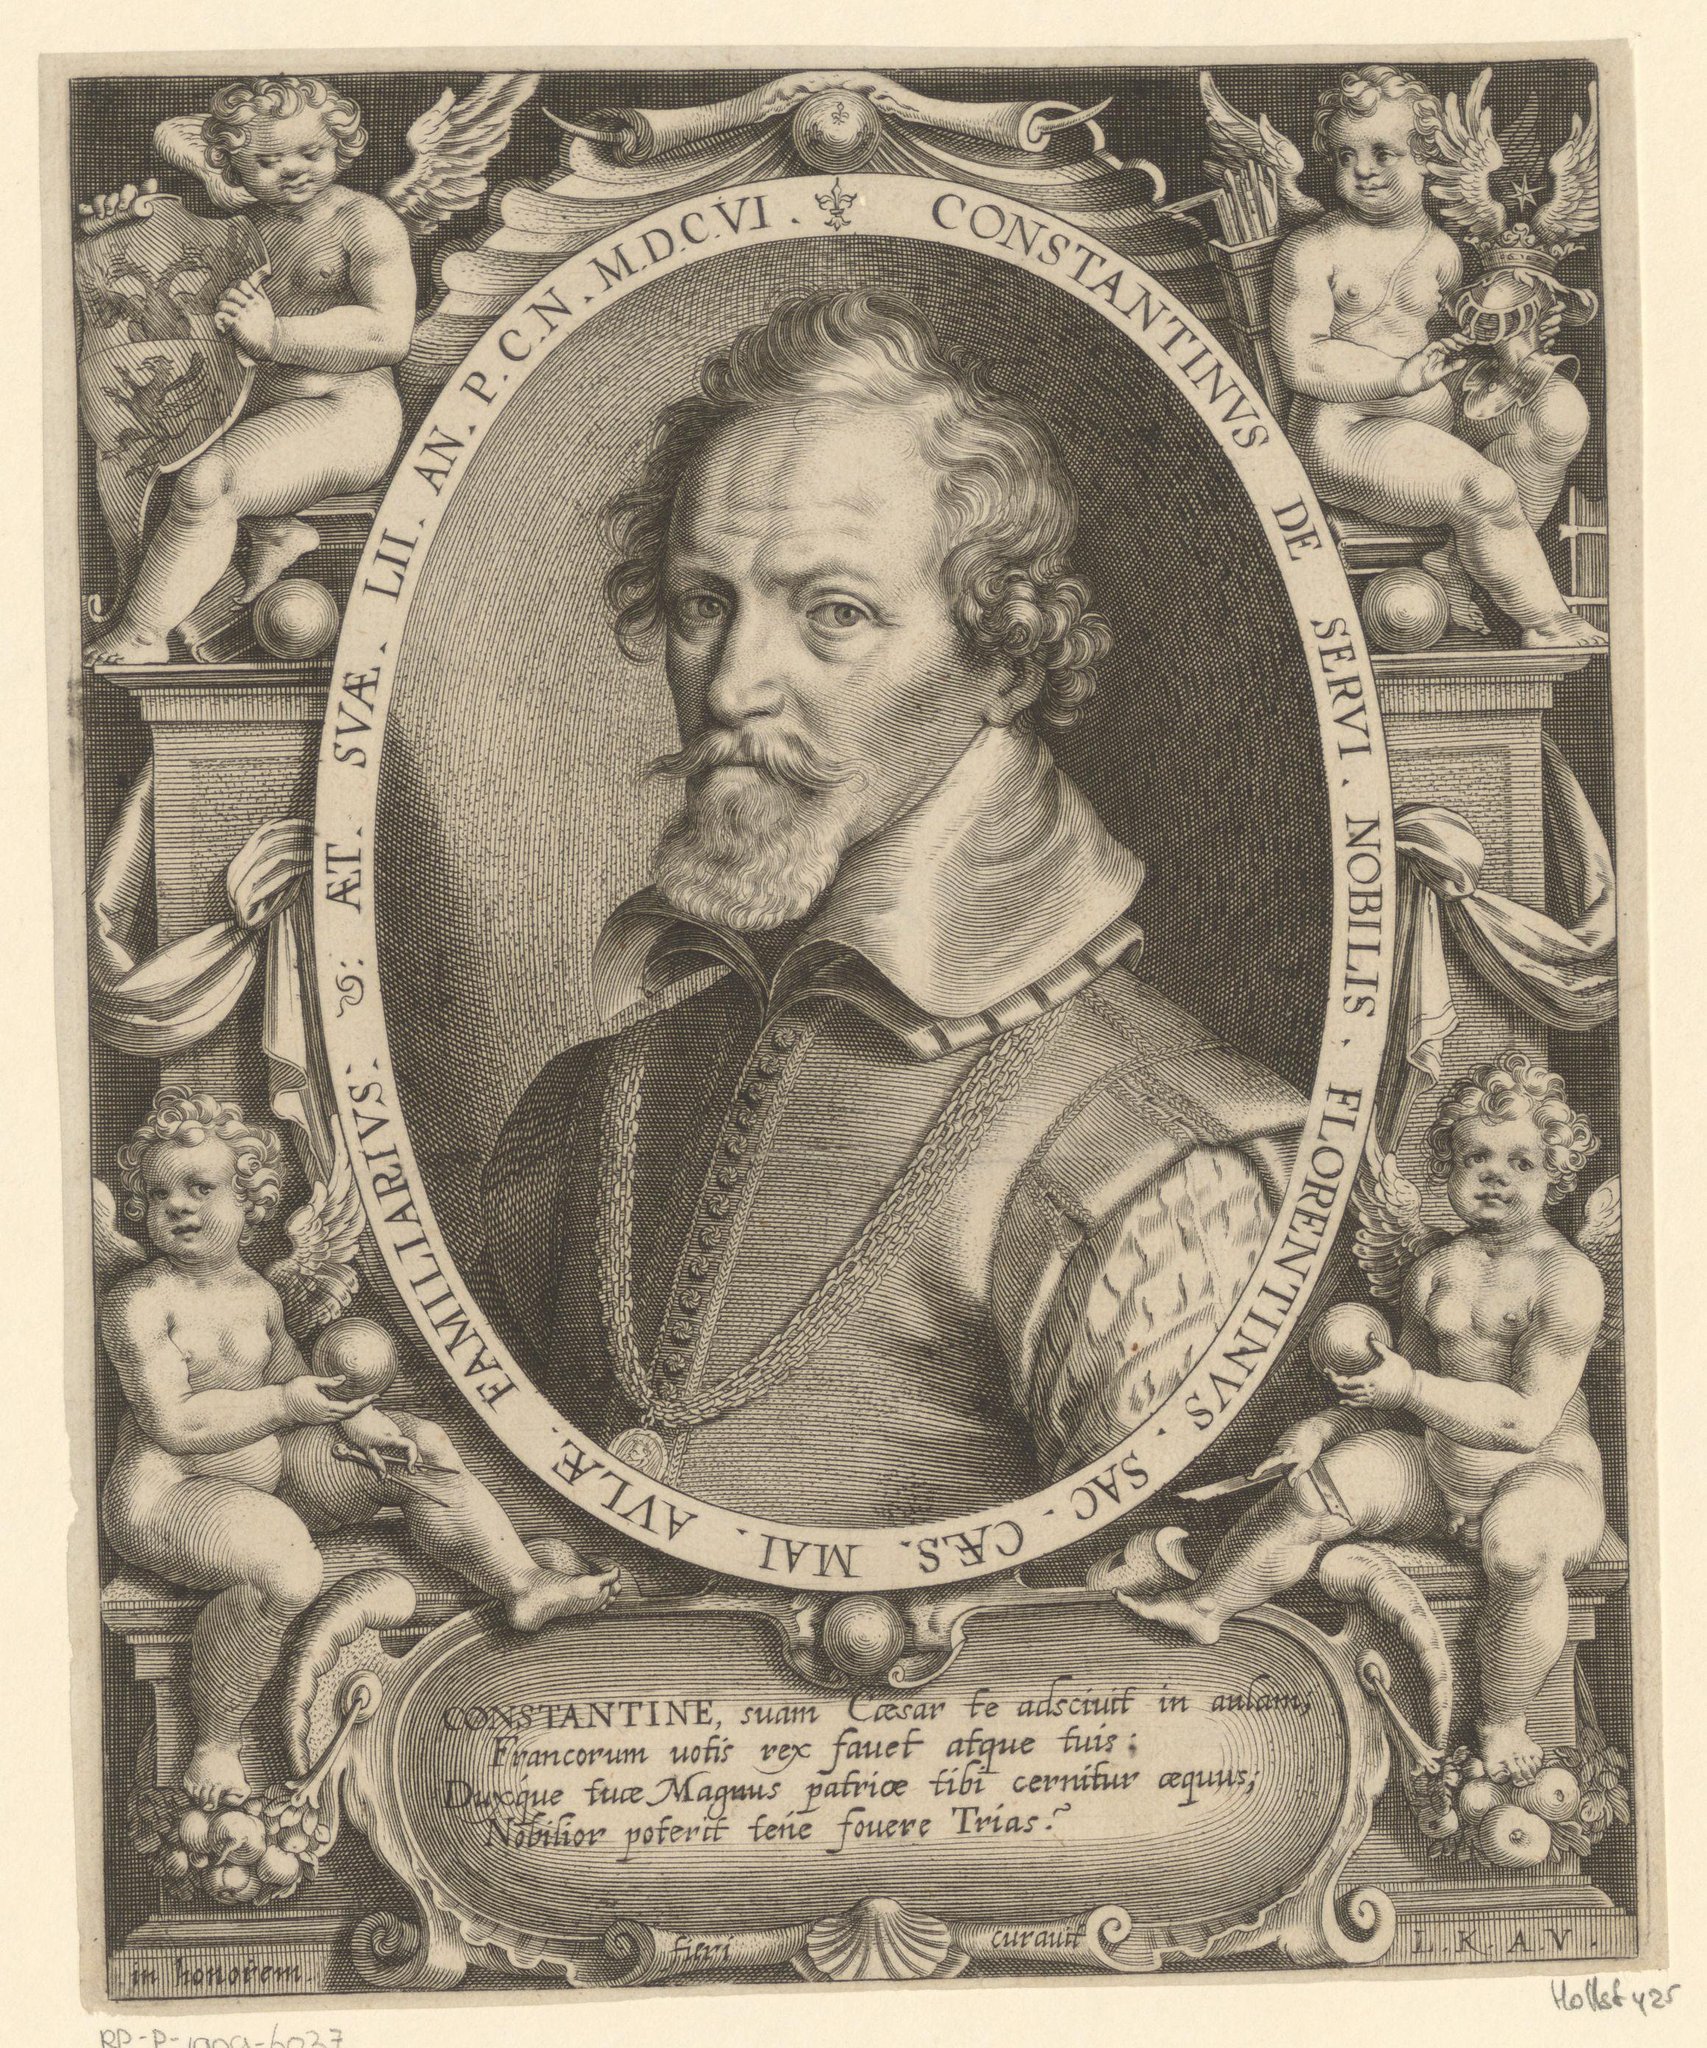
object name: print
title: Portret van Costantino de' Servi op 52-jarige leeftijd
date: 1606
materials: paper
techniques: engraving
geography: augsburg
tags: artist, sculptor, portrait, self-portrait of sculptor, historical persons, portrait, self-portrait of architect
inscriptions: collector's mark: Lugt 2228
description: Vier putti zitten op de sokkels om het portretmedaillon. Tekst in het Latijn in de omlijsting en in de cartouche.